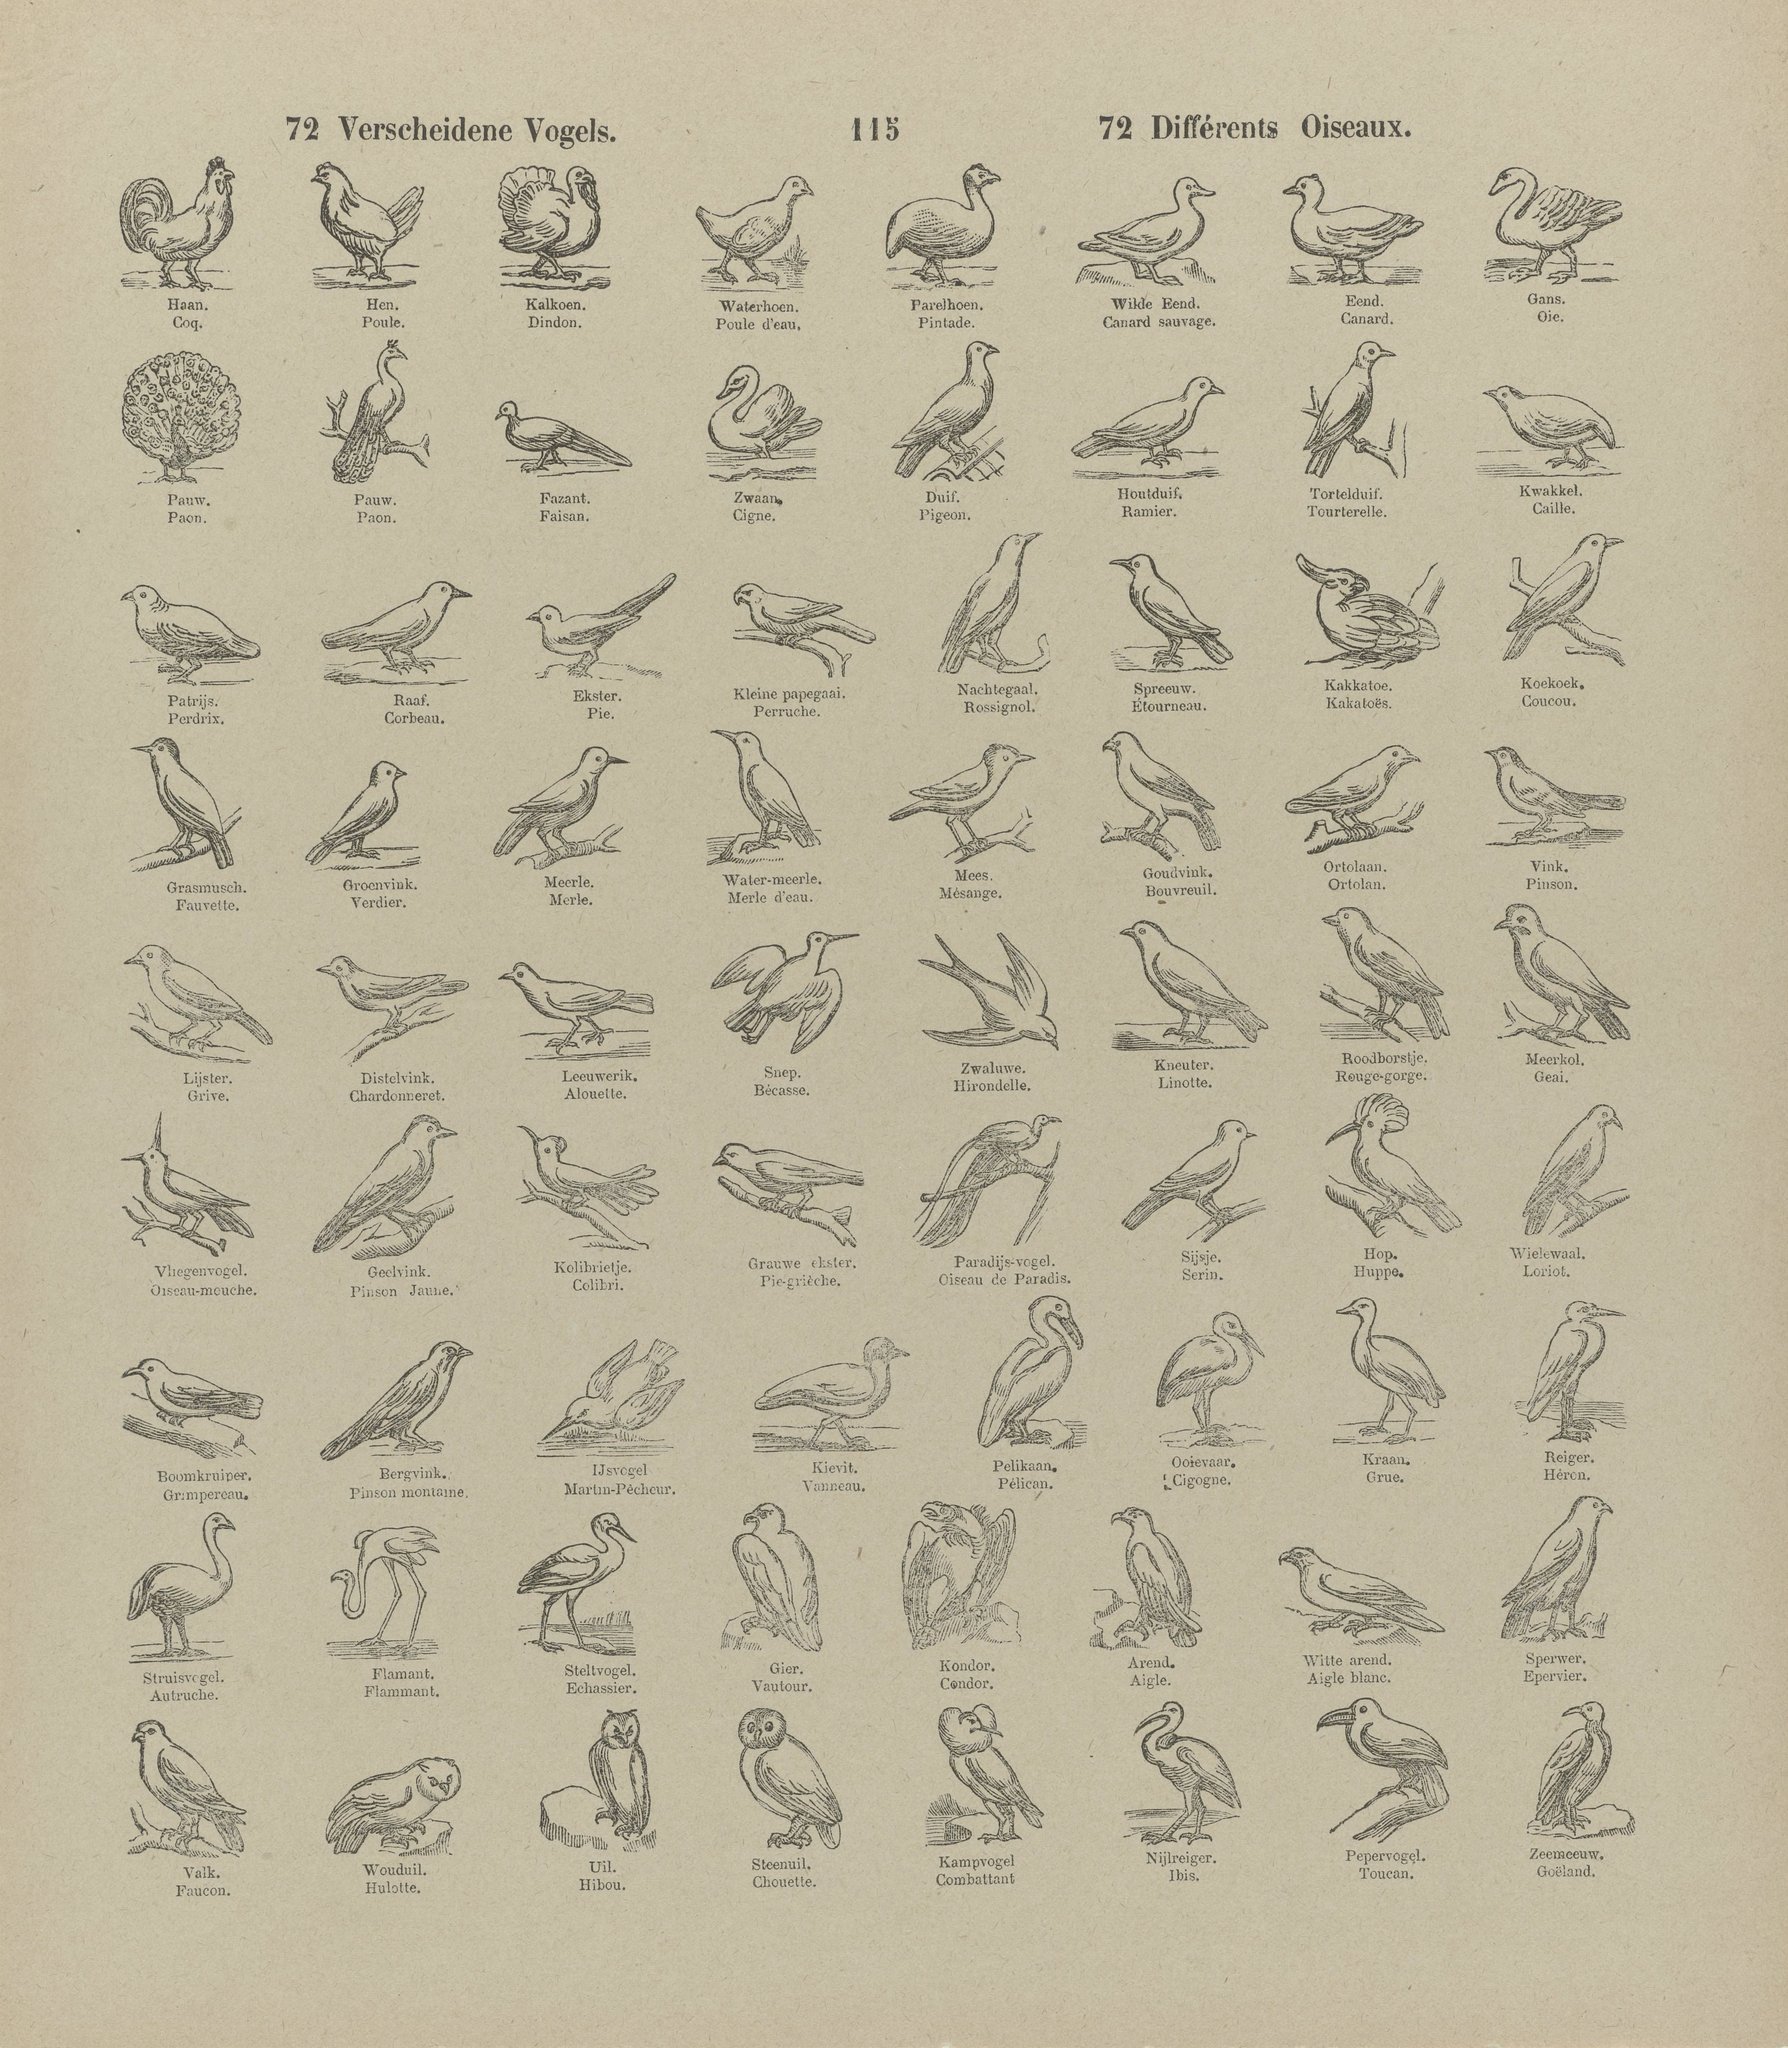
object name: print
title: 72 Verscheidene vogels / 72 Différents oiseaux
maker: Anonymous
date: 1833-1911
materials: paper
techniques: letterpress printing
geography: turnhout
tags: birds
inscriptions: collector's mark: Lugt 2760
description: Blad met 72 voorstellingen van vogels. Onder elke voorstelling de naam van de vogel in het Nederlands en in het Frans. Genummerd midden boven: 115.